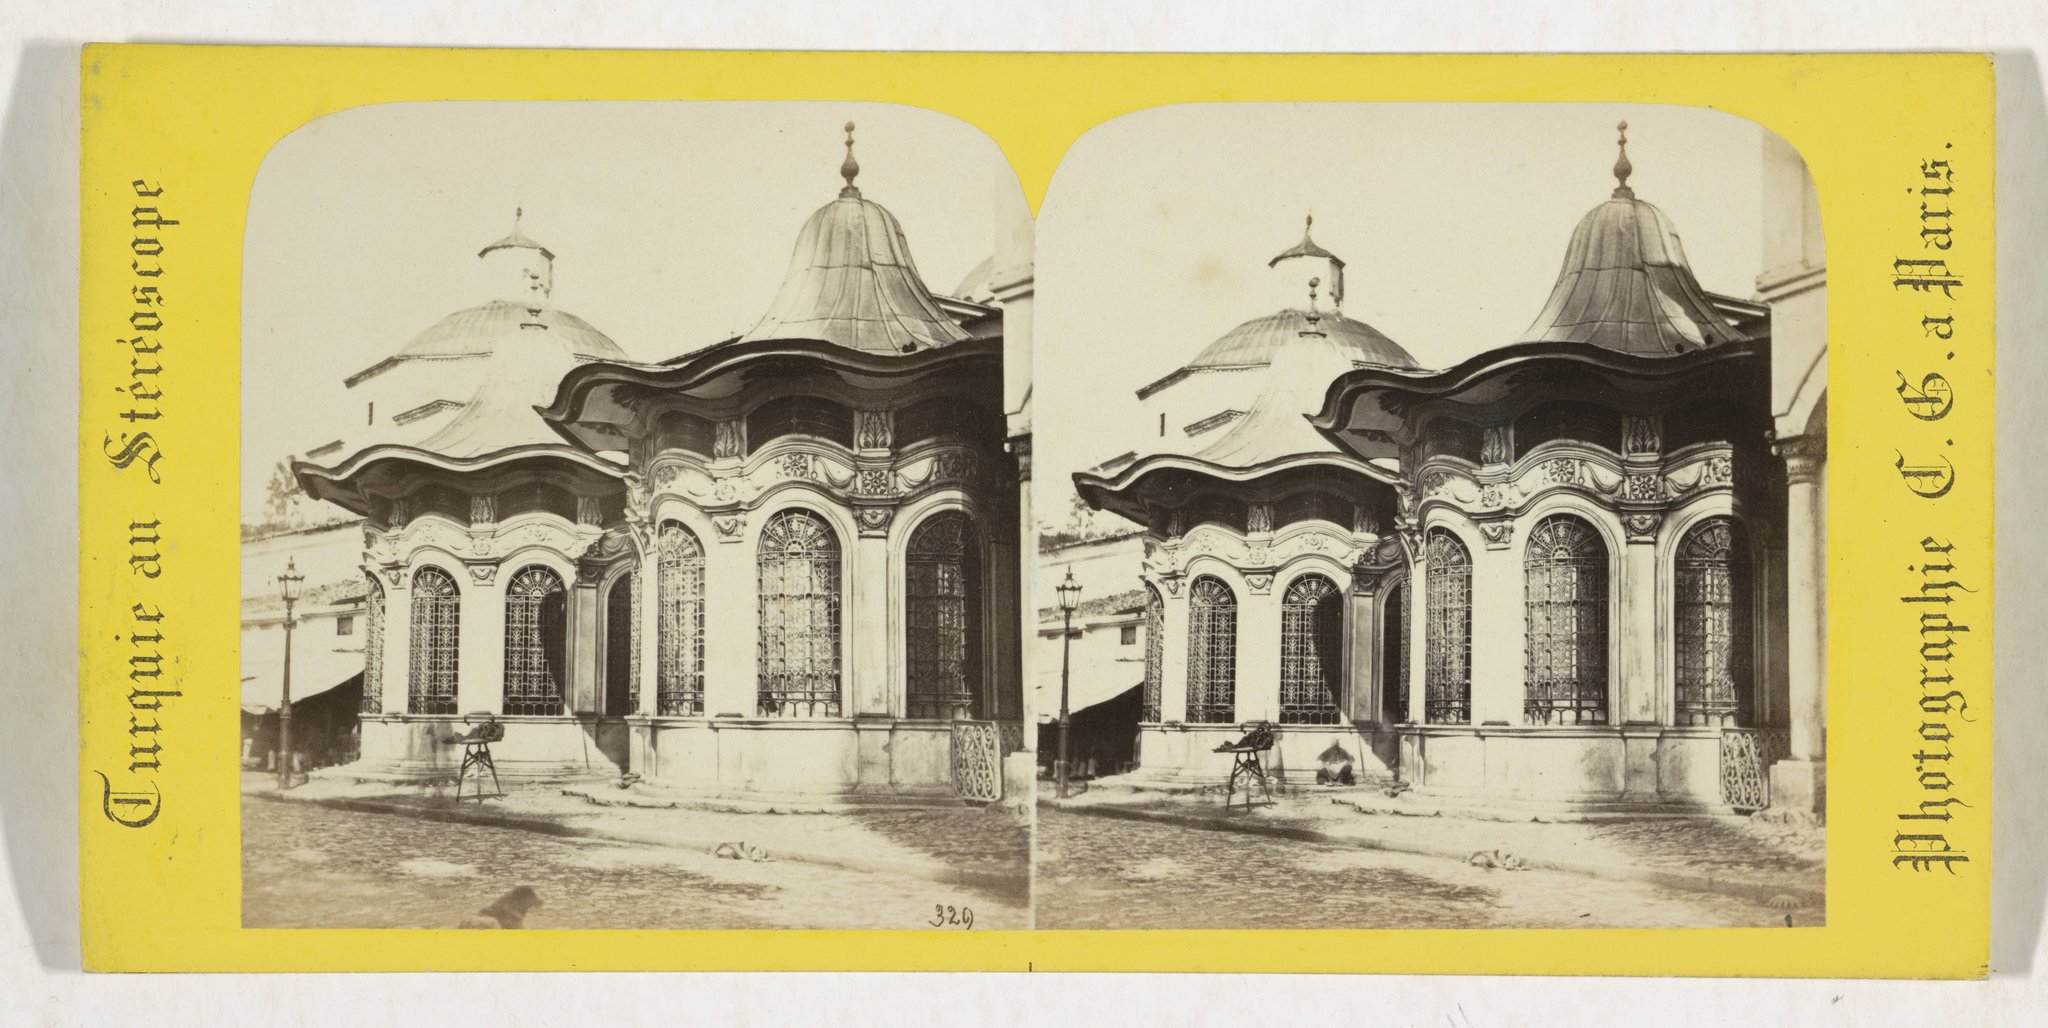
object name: stereograph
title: Turquie au Stéréoscope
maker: charles gaudin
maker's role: publisher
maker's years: 1825-1905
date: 1861-1870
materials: cardboard, paper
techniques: albumen print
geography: kiliç ali pasha complex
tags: temple, shrine ~ islam, mohammedanism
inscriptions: number: ‘329’